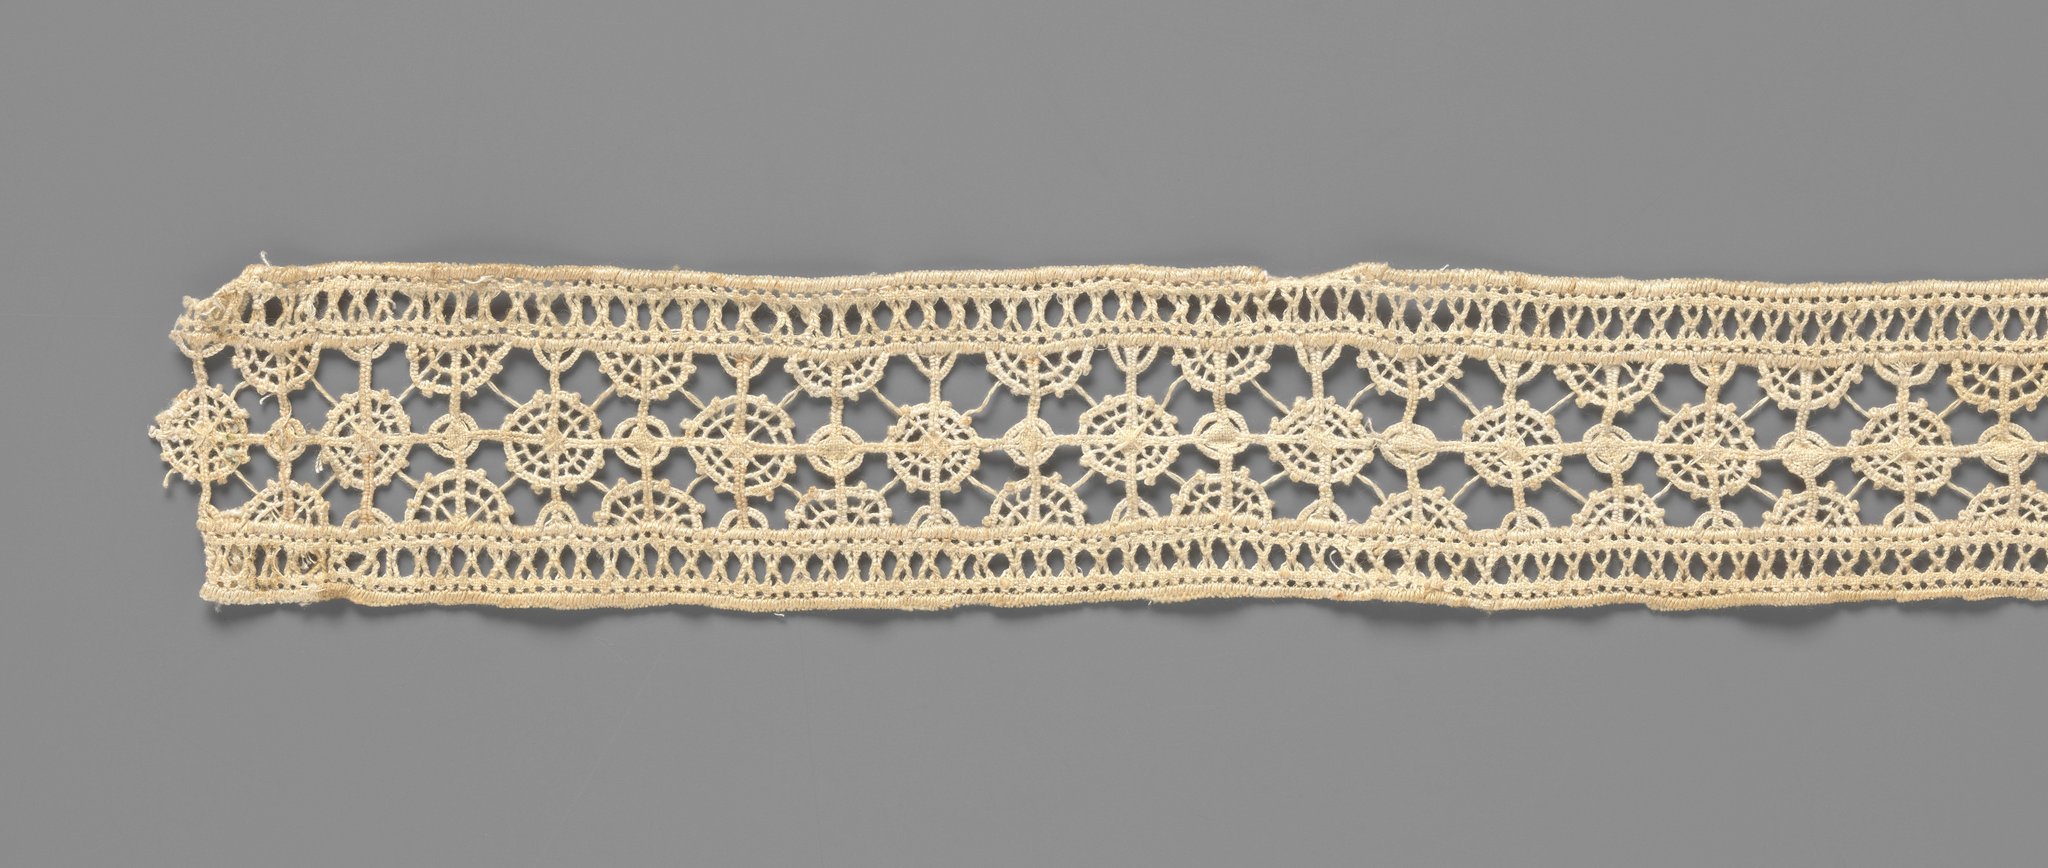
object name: strip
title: Strook naaldkant met kleine dichte en grote open cirkels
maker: Anonymous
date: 1900-1949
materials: cotton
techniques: needle lace, openwork embroidery, reticella, work with drawn threads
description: Strook naturelkleurige naaldkant - reticella - tussen randen open naaiwerk: werk met uitgetrokken draden. Het zich herhalende en symmetrische patroon bestaat uit één rij vierkanten, die zijn opgebouwd uit vier kleine vierkanten. Elk groot vierkant is doorkruisd, op elk kruispunt om en om een kleine dichtgewerkte en een grote opengewerkte cirkel. Langs de randen halve cirkels. De boven- en onderzijde van de strook zijn recht afgewerkt met open ruitjes (werk met uitgetrokken draden).